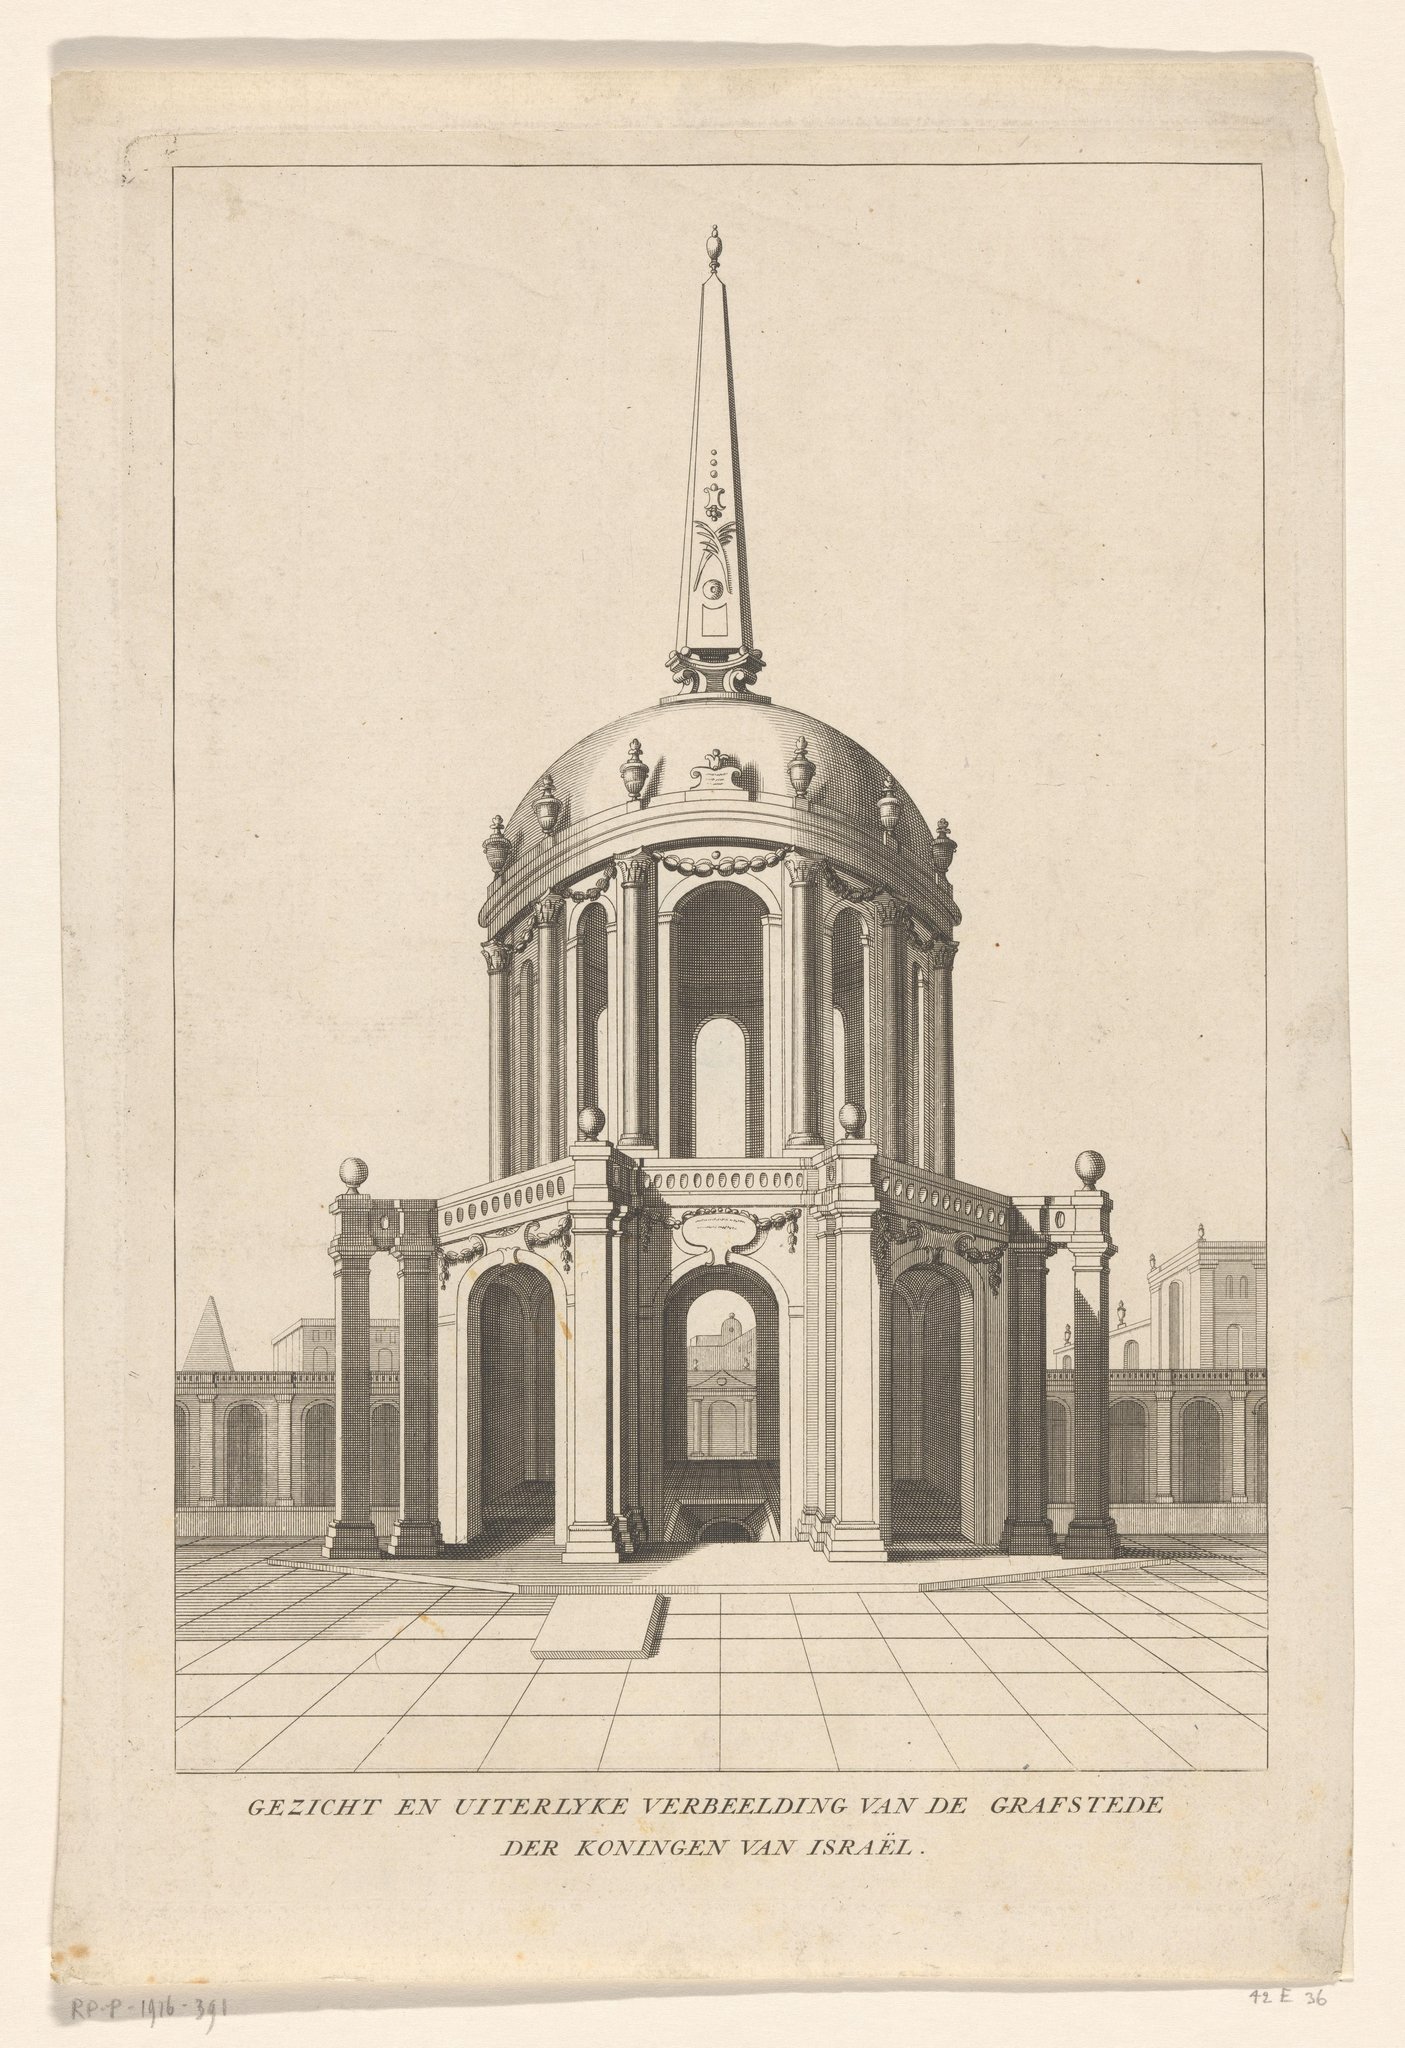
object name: print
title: Gezicht en uiterlyke verbeelding van de grafstede der koningen van Israël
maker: Anonymous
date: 1725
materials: paper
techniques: engraving, etching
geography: netherlands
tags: other memorial structures, old testament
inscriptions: collector's mark: Lugt 2228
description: Gebruikt als illustratie in: Het algemeen groot historisch, oordeelkundig, chronologisch, geografisch, en letterlyk naam- en woord-boek, van den gantschen H. Bijbel. Dienende tot de gedenk-stukken der Jooden en andere oudheden, ter opheldering der H. Schrift . Nu in't Nederduitsch overgezet, merkelyk vermeerdert, en met aanmerkingen verrykt, door Mattheus Gargon.' and it's additons: 'Byvogzel tot het algemeen groot . Naam- en woord-boek . En nu in zuiver Nederduitsch overgezet, merkelyk vermeerdert, en metv aanmerkingen verrykt, door Jakob van Ostade en Arn. Henr. Westerhovius.', by Augustines Calmet, published in Leiden, Amsterdam, by Samuel Luchtmans, R. & J. Wetstein en Smith 1725-1731. Dl. I (1725), p. 92/93. De prenten in dit werk zijn vervaardigd door: A. de Putter, F. van Bleyswyk, M. Pool, Ph. van Gunst, e.a.